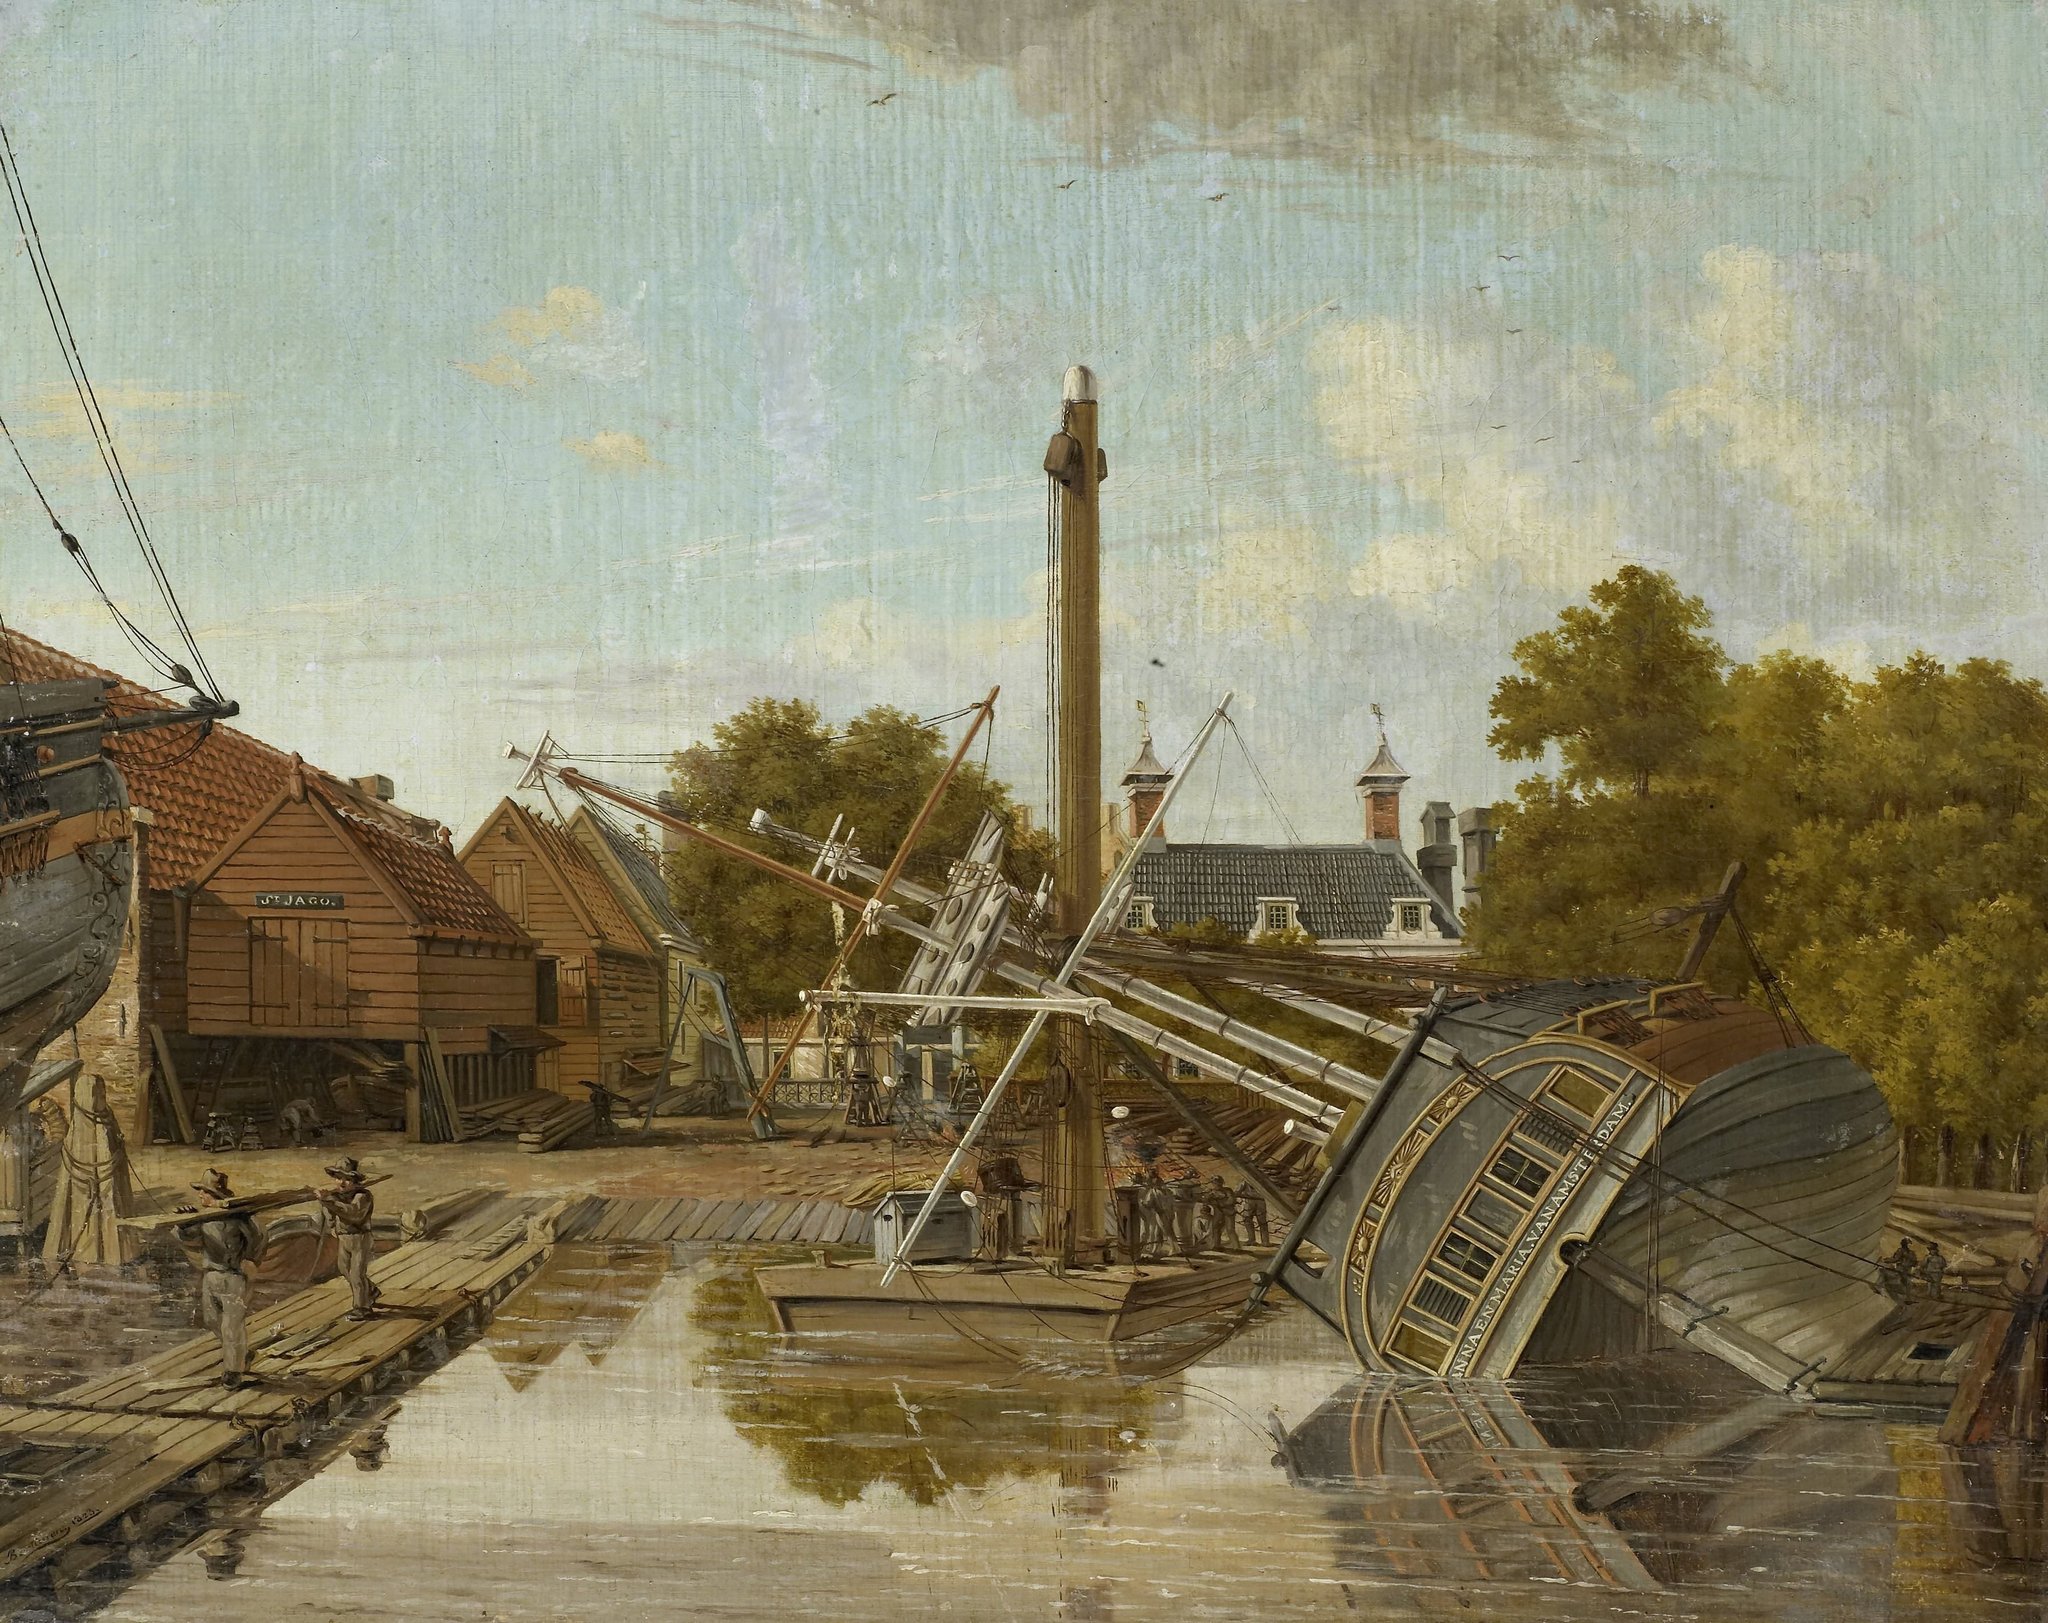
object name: painting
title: The Shipyard 'St Jago'on Bickers Eiland, Amsterdam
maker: pieter godfried bertichen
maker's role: draughtsman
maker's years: 1796-1833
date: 1823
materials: canvas, oil, panel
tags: shipyard, shipdock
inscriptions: signature and date: ‘Bertichen. 1823.’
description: De scheepstimmerwerf 'St Jago' op het Bickers Eiland te Amsterdam. Rechts het schip de 'Anna en Maria van Amsterdam'. Pendant van SK-C-1539.